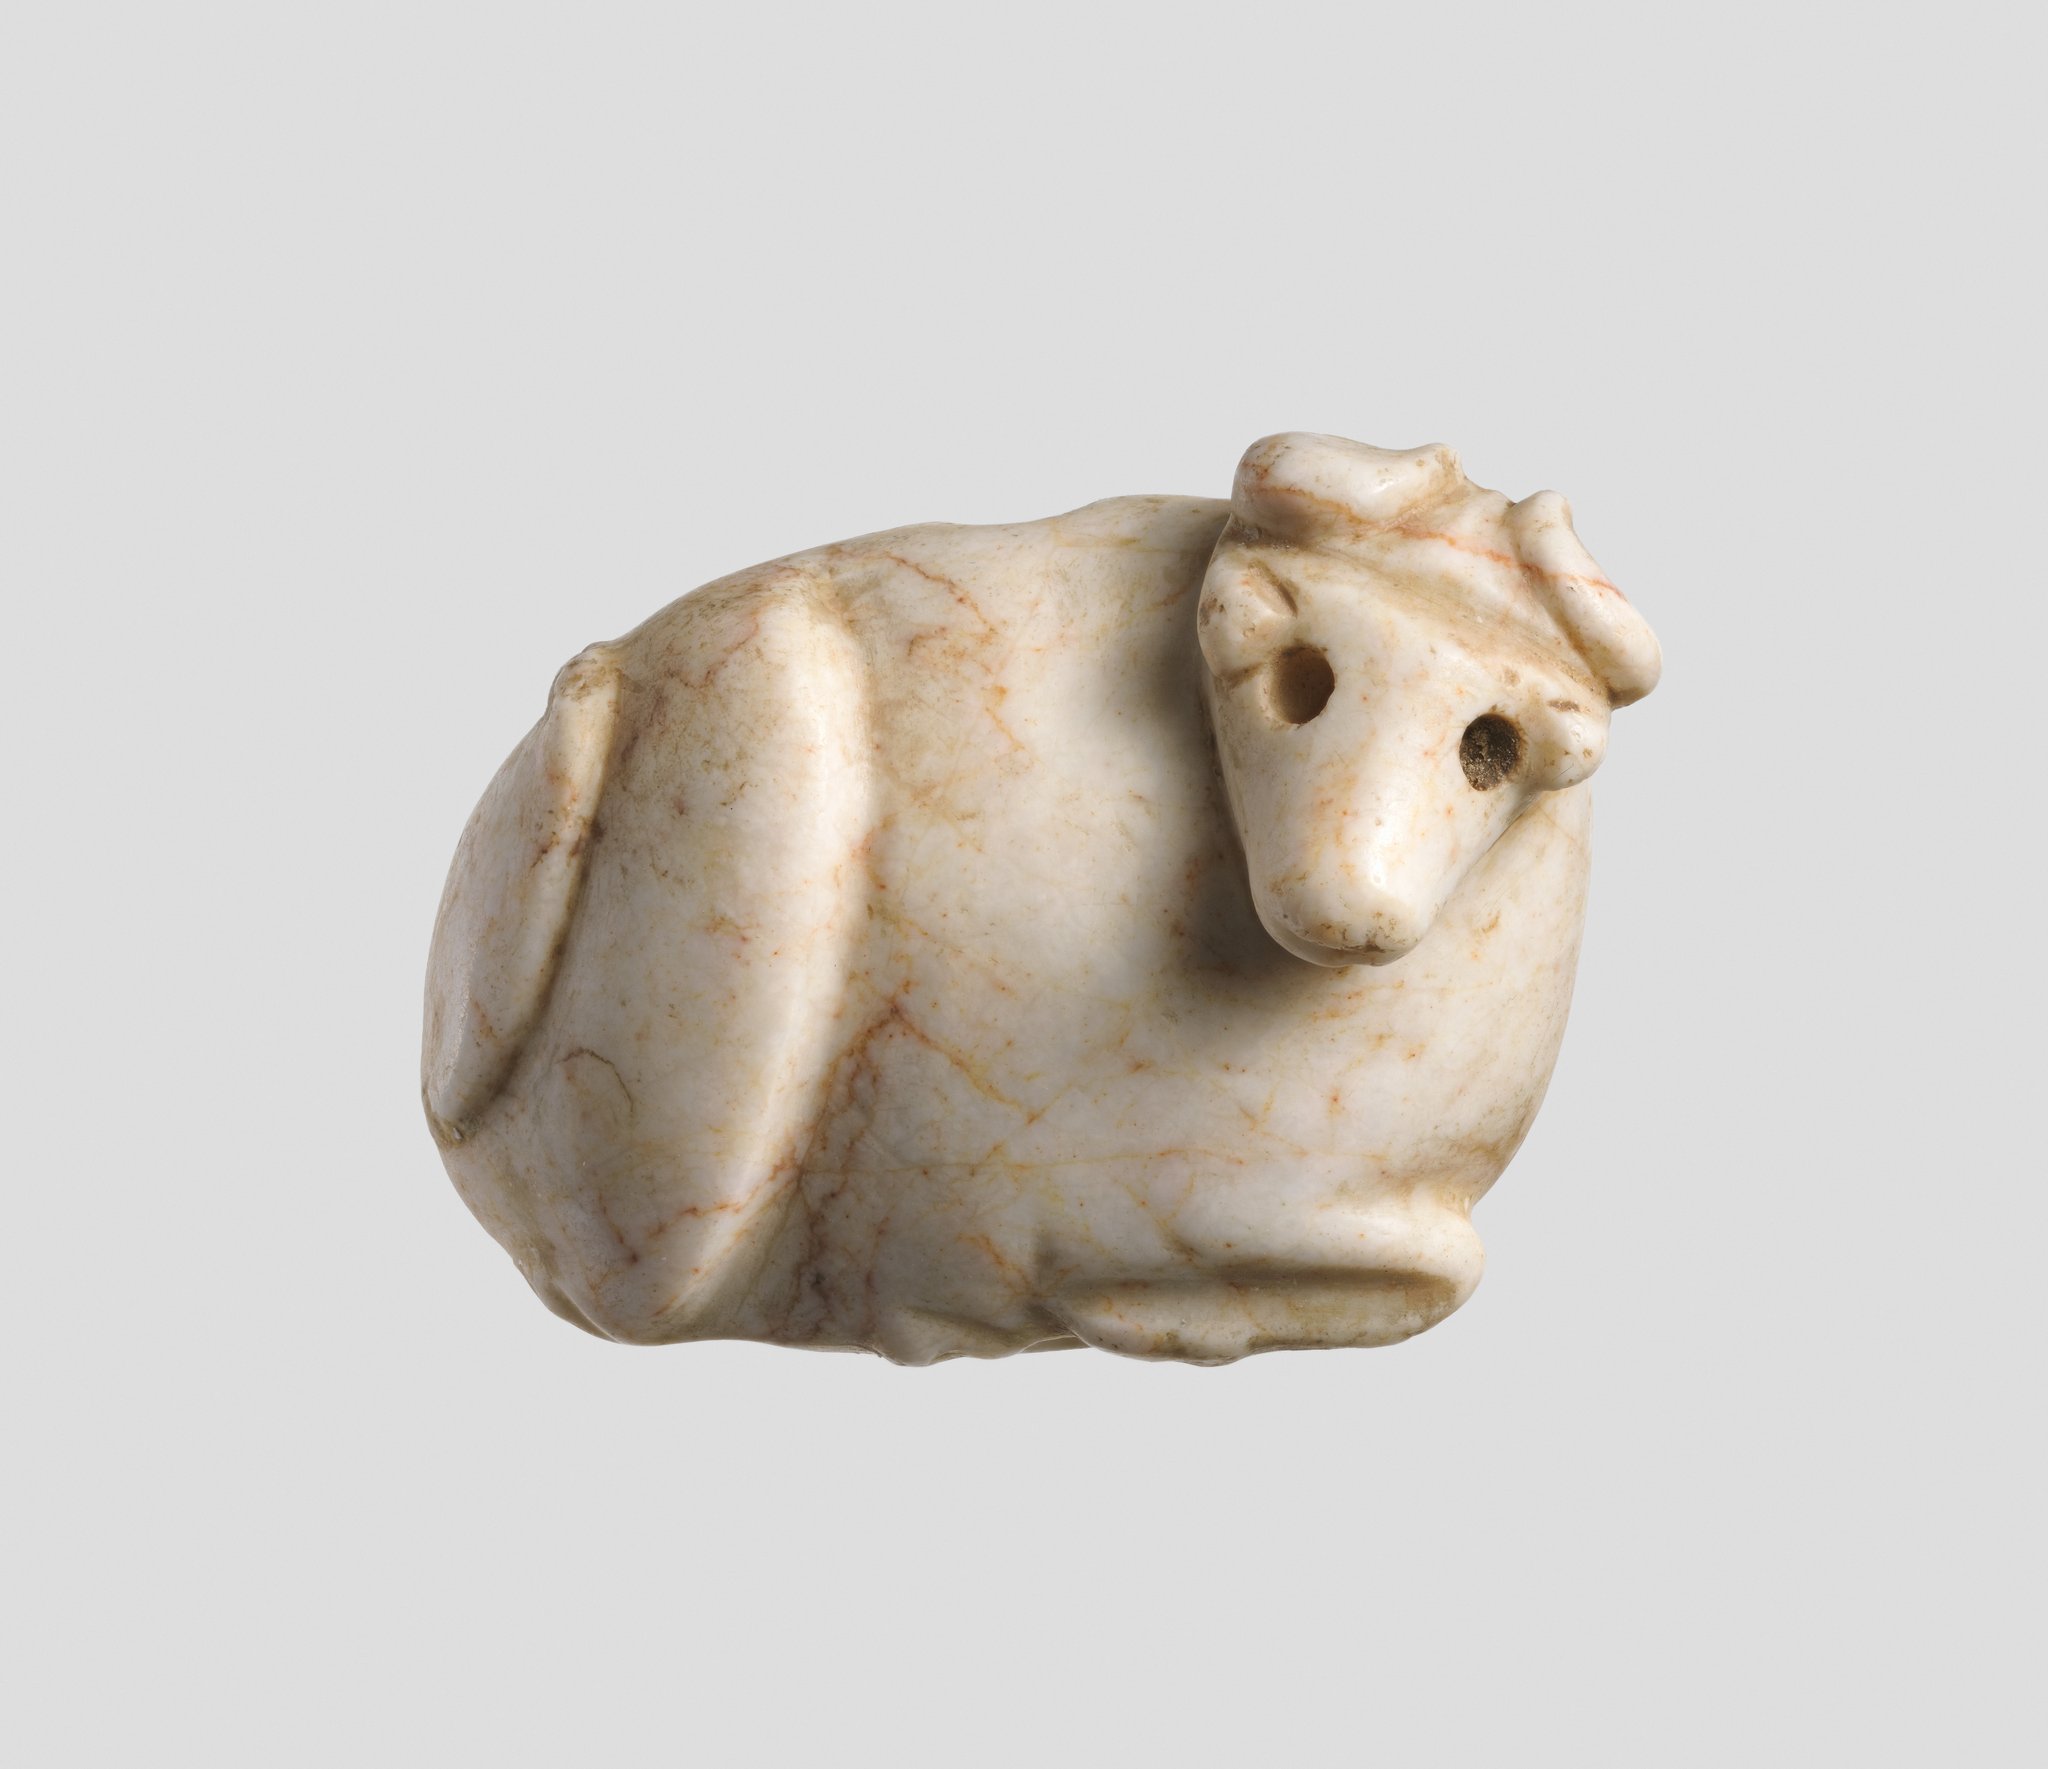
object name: stamp seal amulet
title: Seal amulet in the form of a reclining cow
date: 3300-2900 BCE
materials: marble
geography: southern mesopotamia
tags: cows